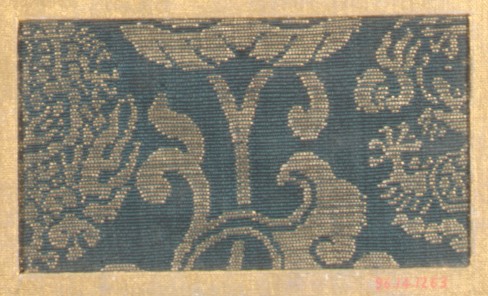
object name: piece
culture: japanese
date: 1701-1900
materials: silk